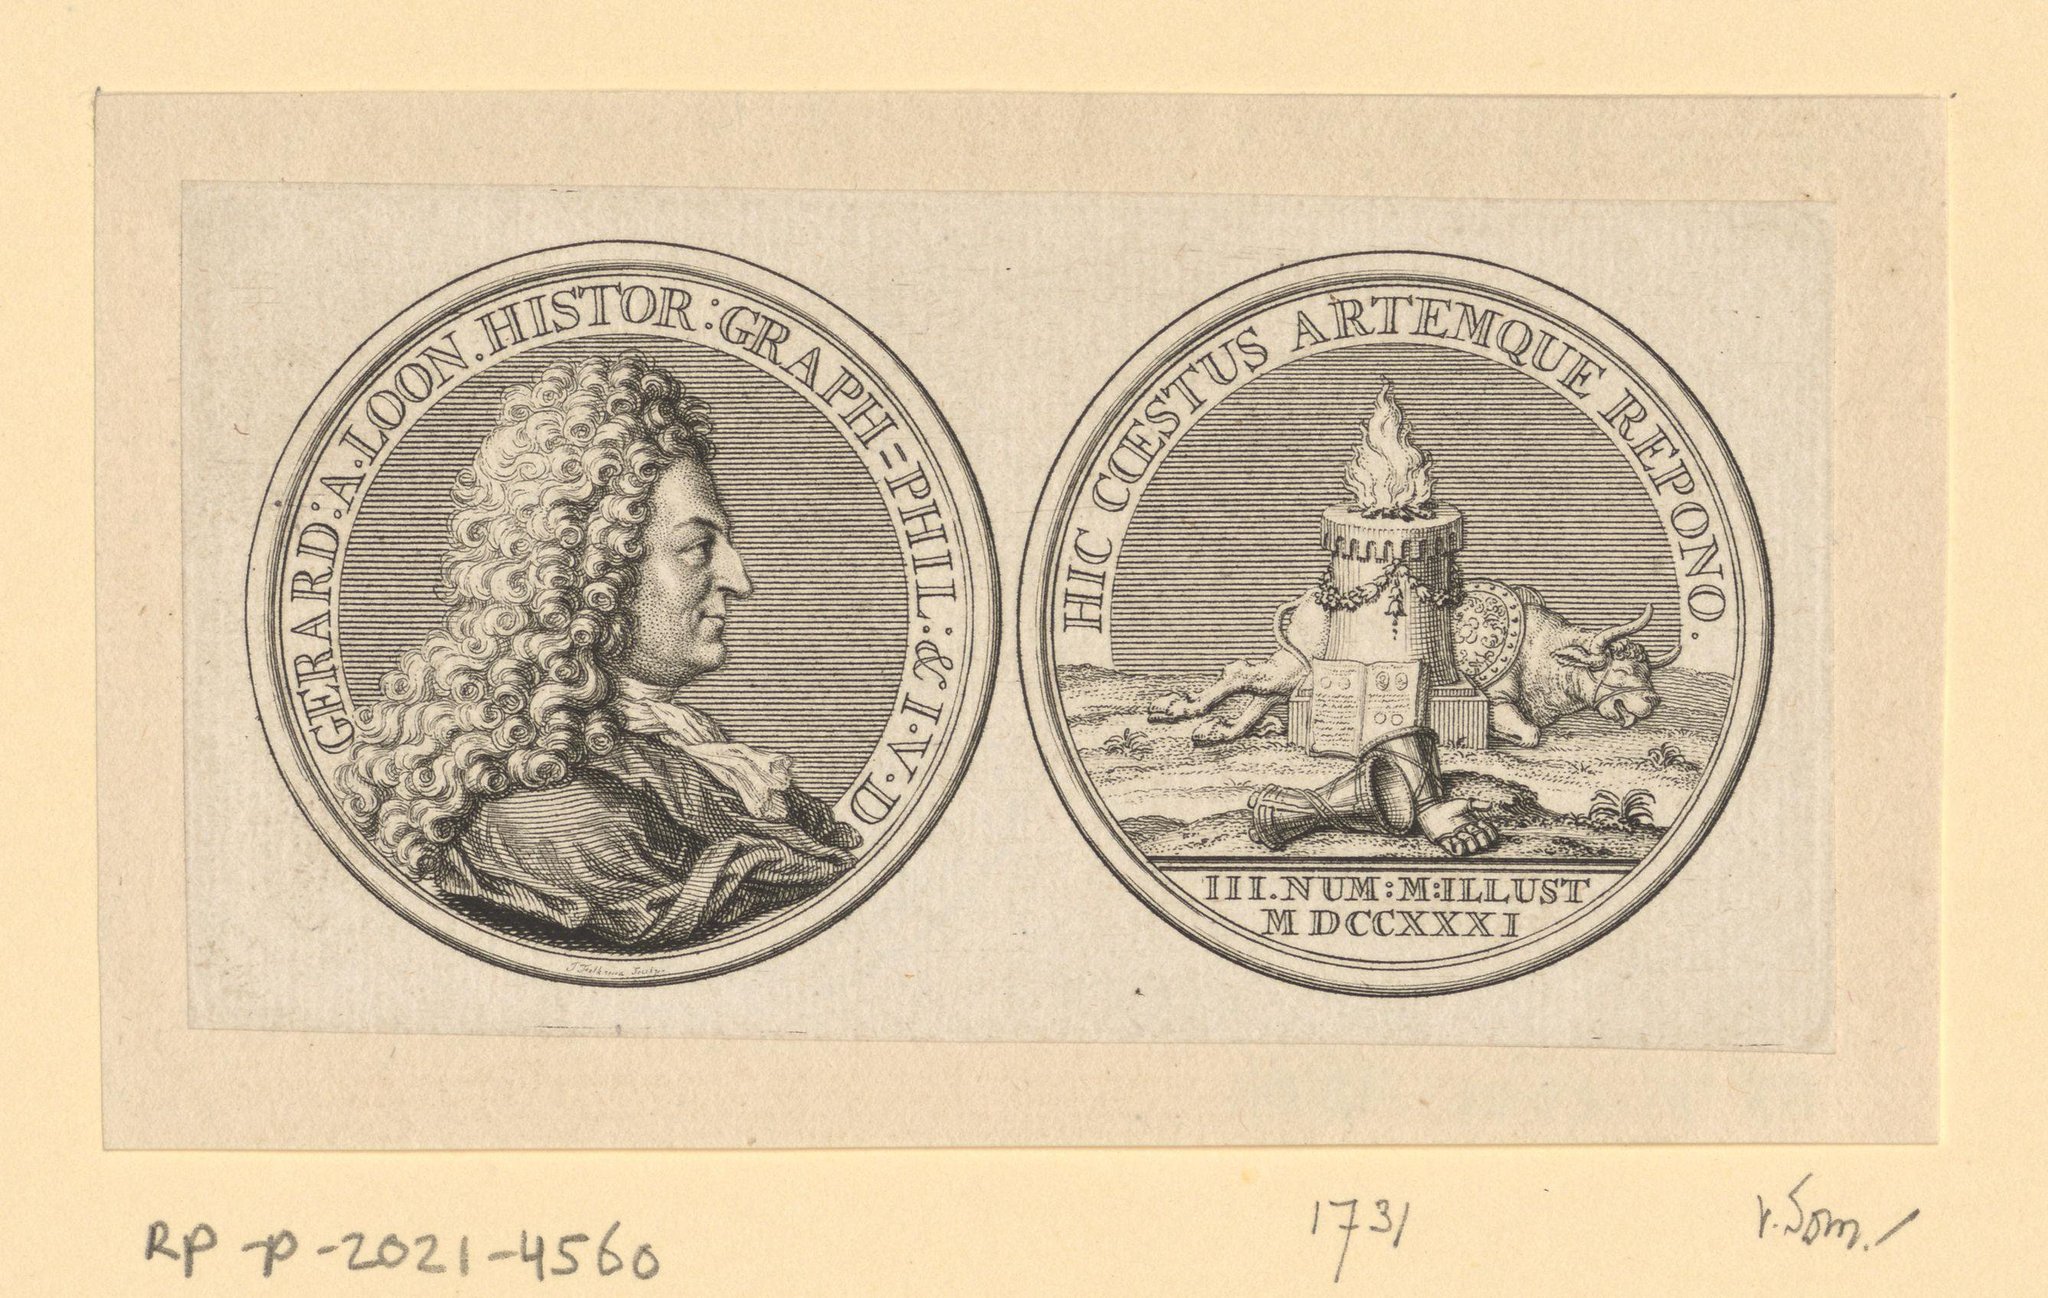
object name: print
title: Voor- en achterzijde van een penning met het portret van Gerard van Loon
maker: Anonymous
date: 1731-1750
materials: paper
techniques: etching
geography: netherlands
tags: designer, gerard van loon, historical persons, medal (considered as a piece of sculpture, regardless of its specific function)